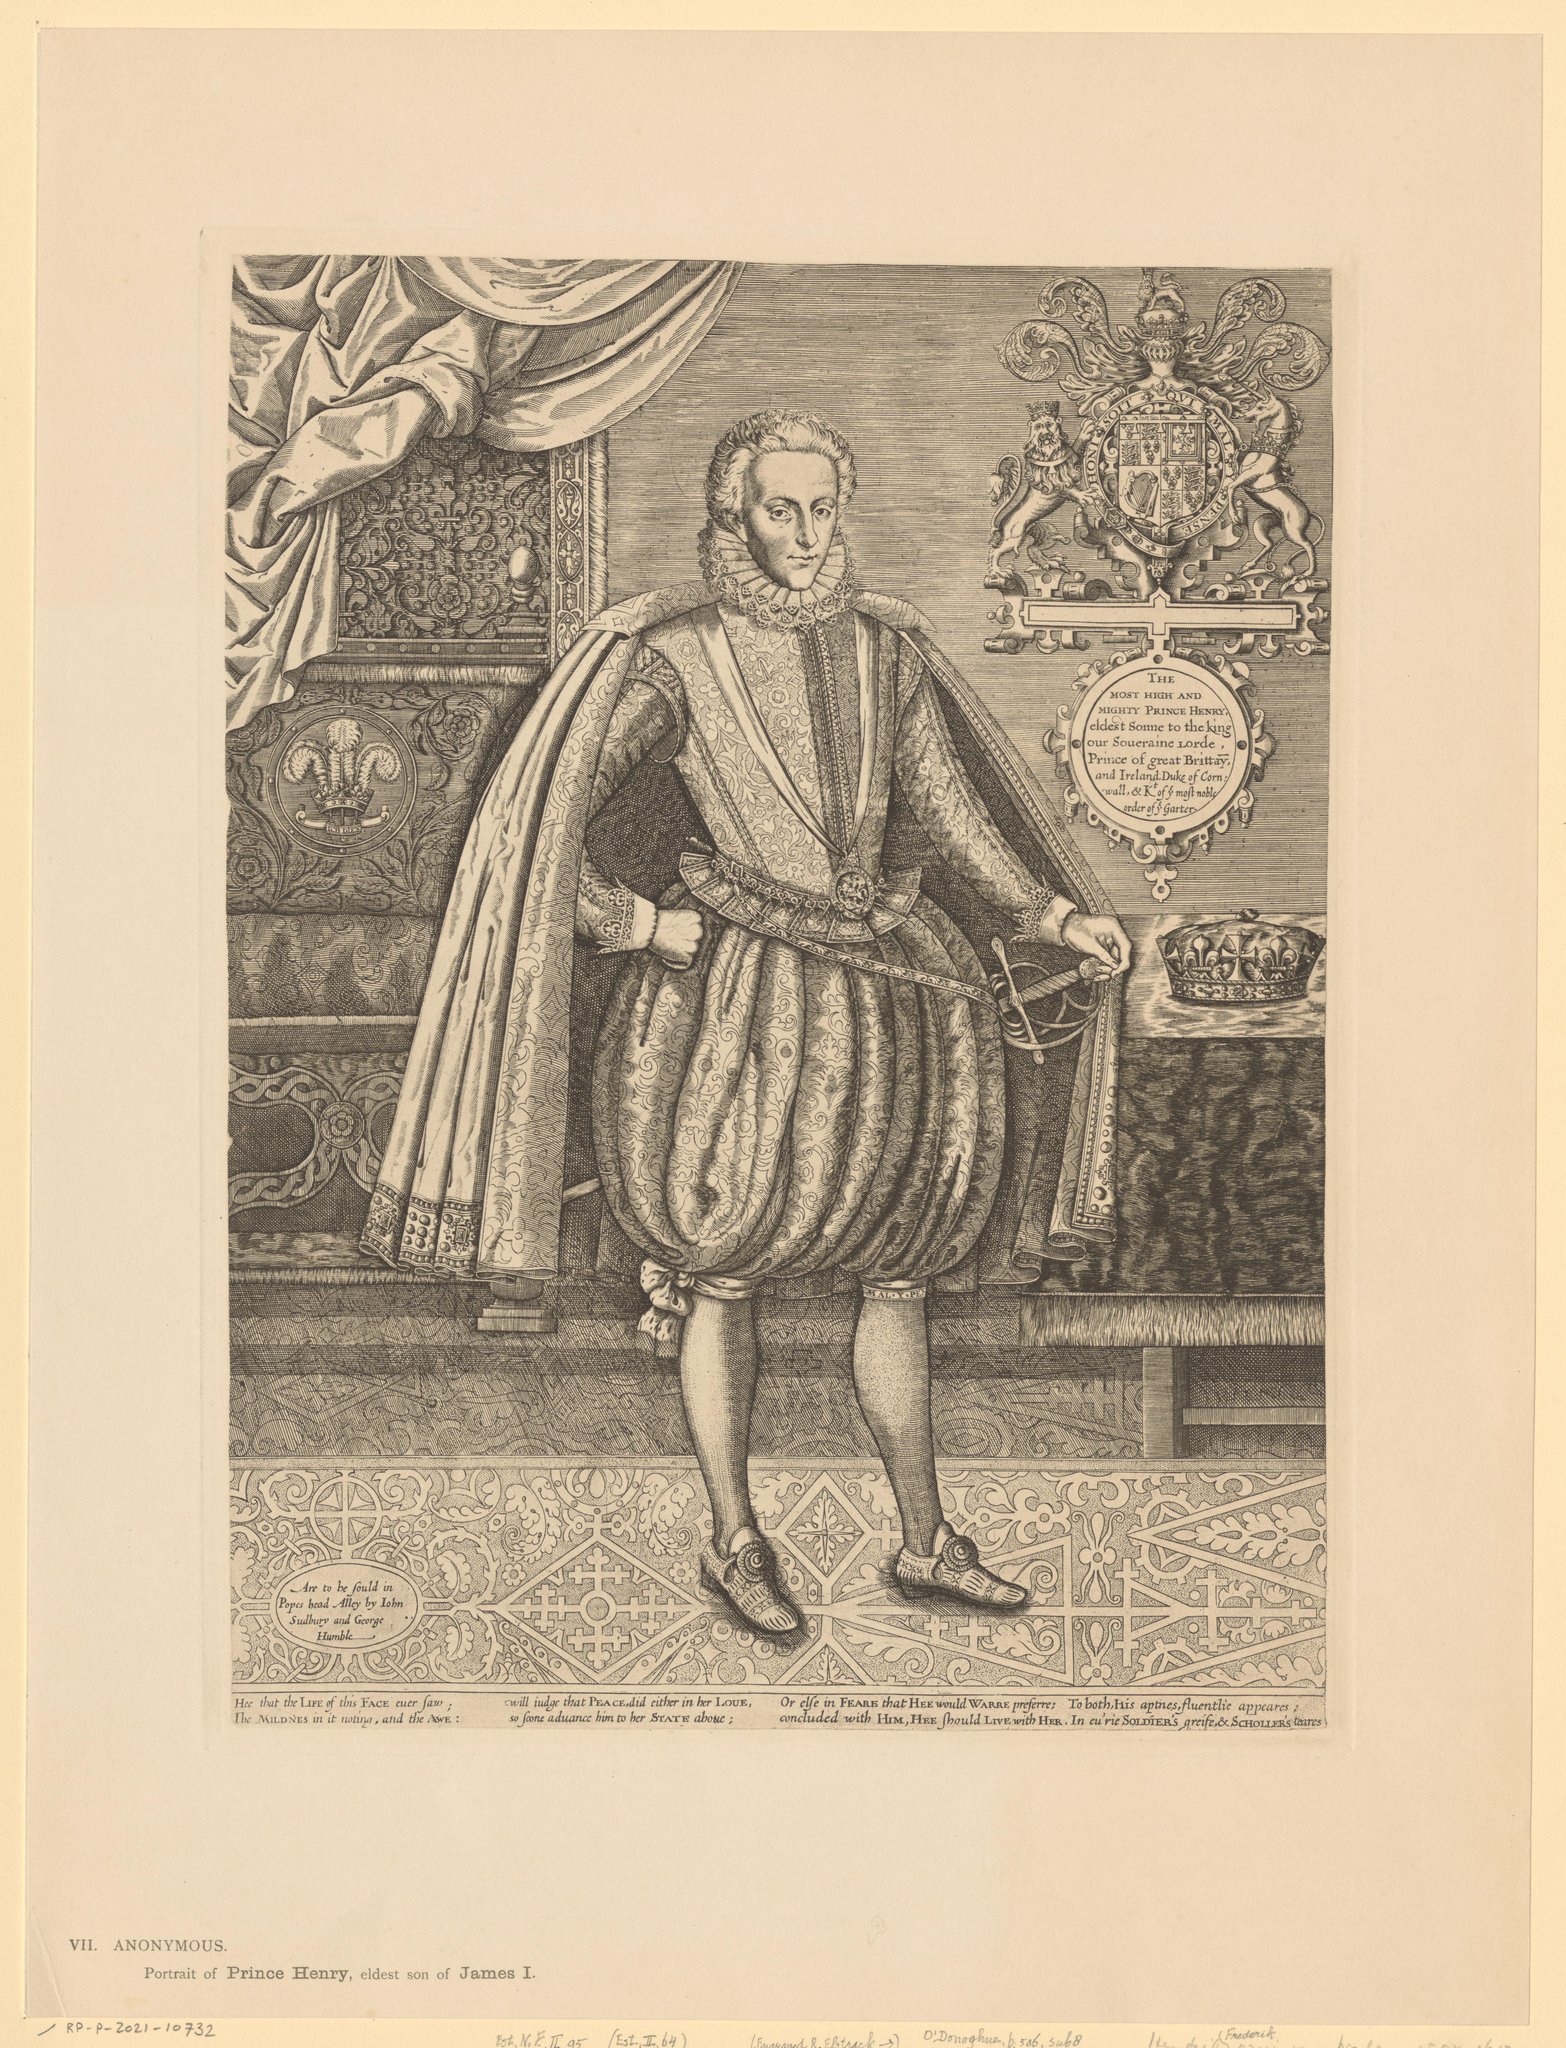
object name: photomechanical print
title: Portrait of Prince Henry, eldest son of James I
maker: Anonymous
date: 1870-1915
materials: paper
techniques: photoaquatint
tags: historical persons, armorial bearing, heraldry, crown prince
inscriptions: collector's mark: Lugt 2166, collector's mark: ‘B’